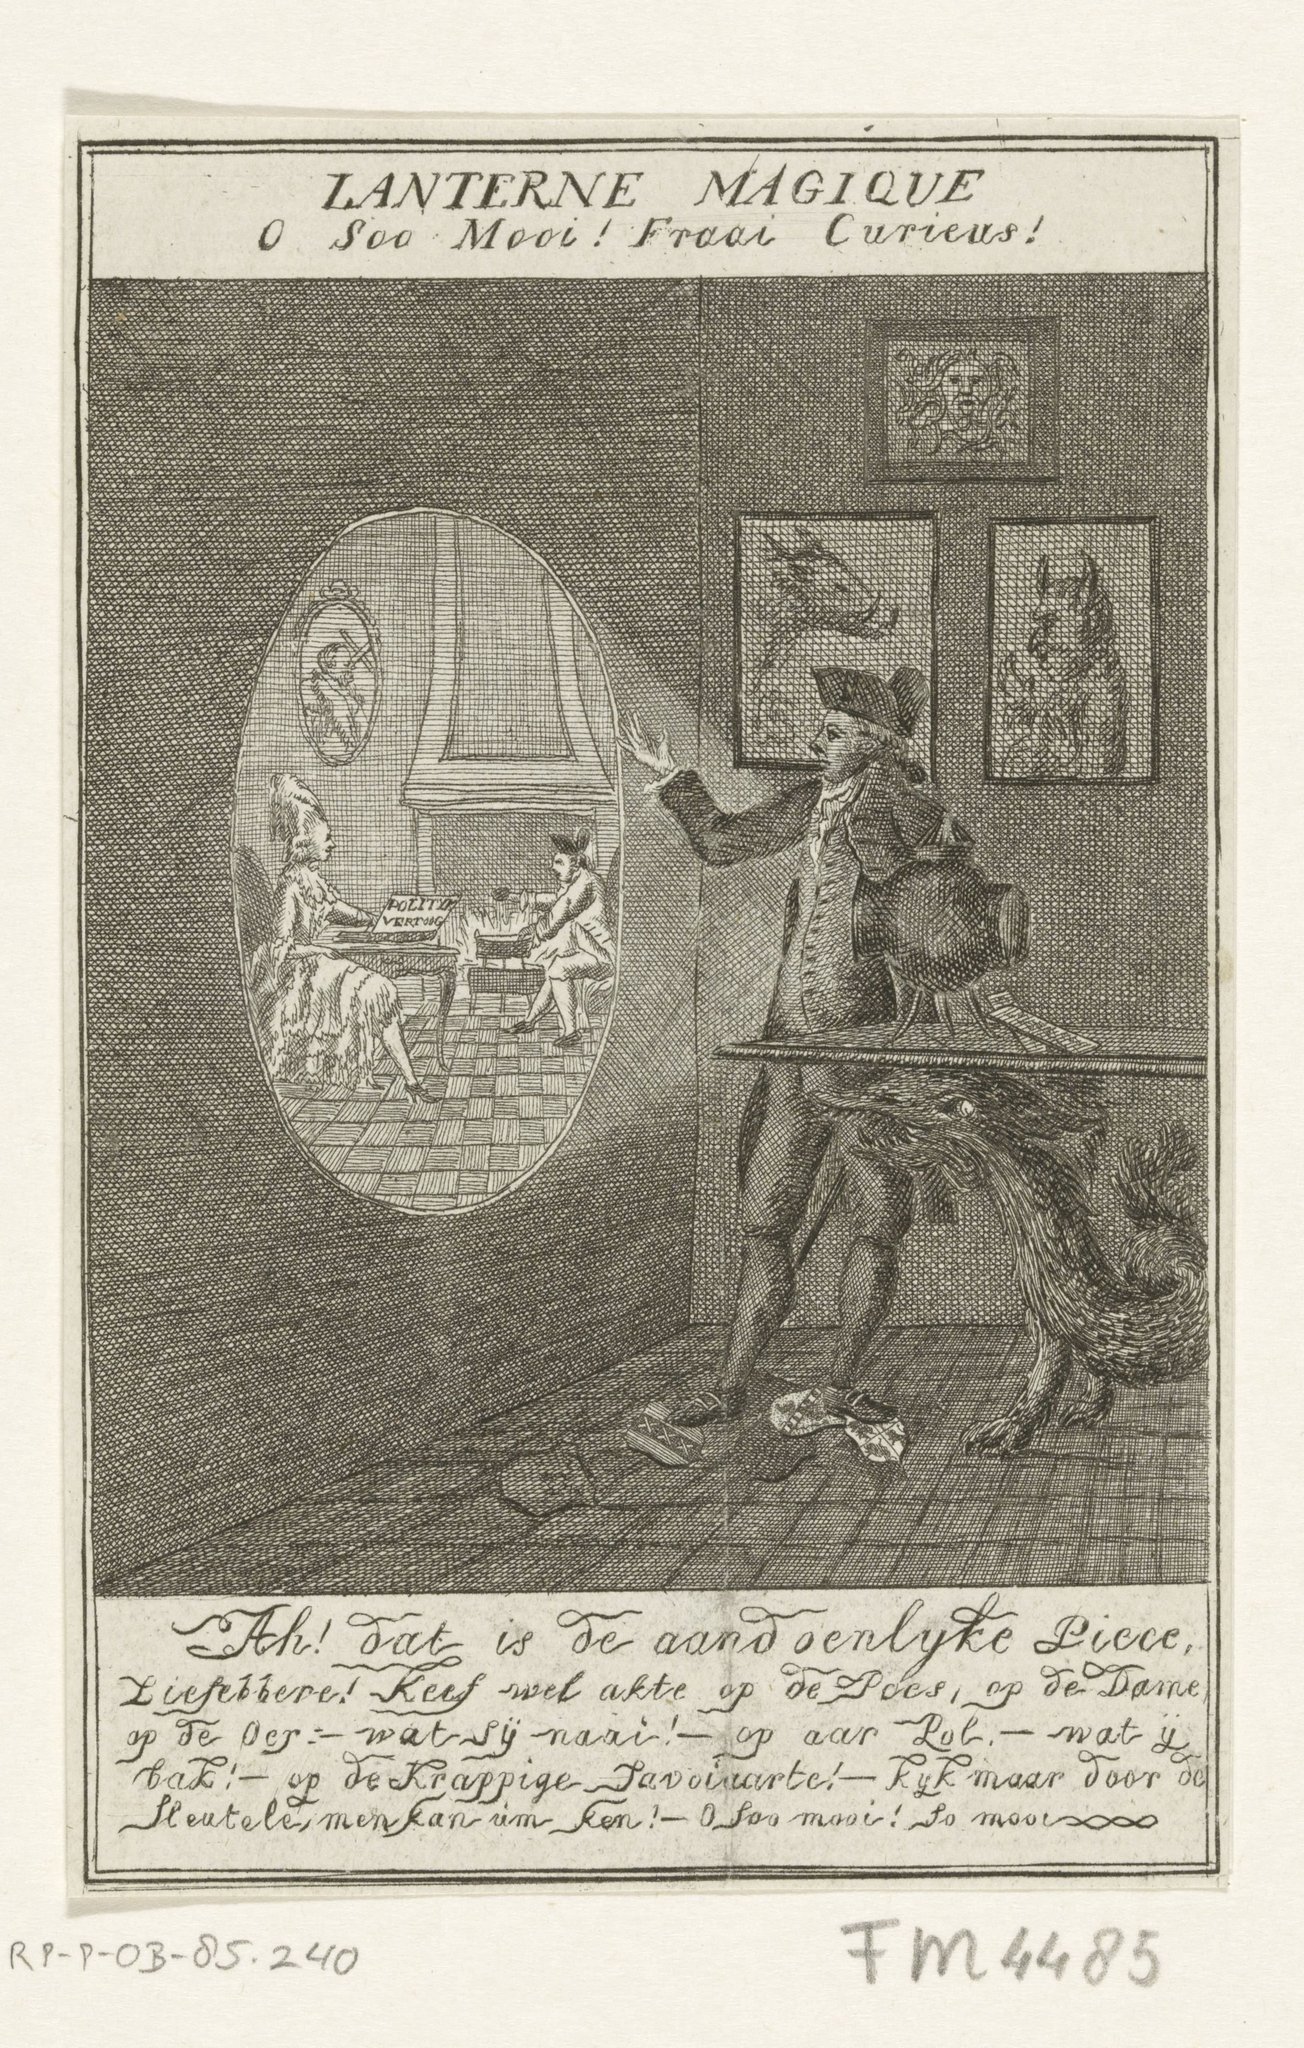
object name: print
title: Lanterne Magique O Soo Mooi! Fraai Curieus!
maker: Anonymous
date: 1782-1784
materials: paper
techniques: engraving, etching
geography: northern netherlands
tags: performance in tents (pleasure fair), cinematographic apparatus, patriots (1780-1795)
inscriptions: collector's mark: Lugt 2228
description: Spotprent op Rijklof Michael van Goens, ca. 1782-1784. Een Savoyaard vertoont met een toverlantaarn een voorstelling van R.M. van Goens die bij de haard oliekoeken bakt, bij hem, met opgeschorte rok, zijn vermeende maîtresse juffrouw ten Bosch met het pamflet getiteld Politiek Vertoog. De Savoyaard vertreedt onder zijn voeten de wapens van Amsterdam en de prins. Met vijfregelig onderschrift in koeterwaals.